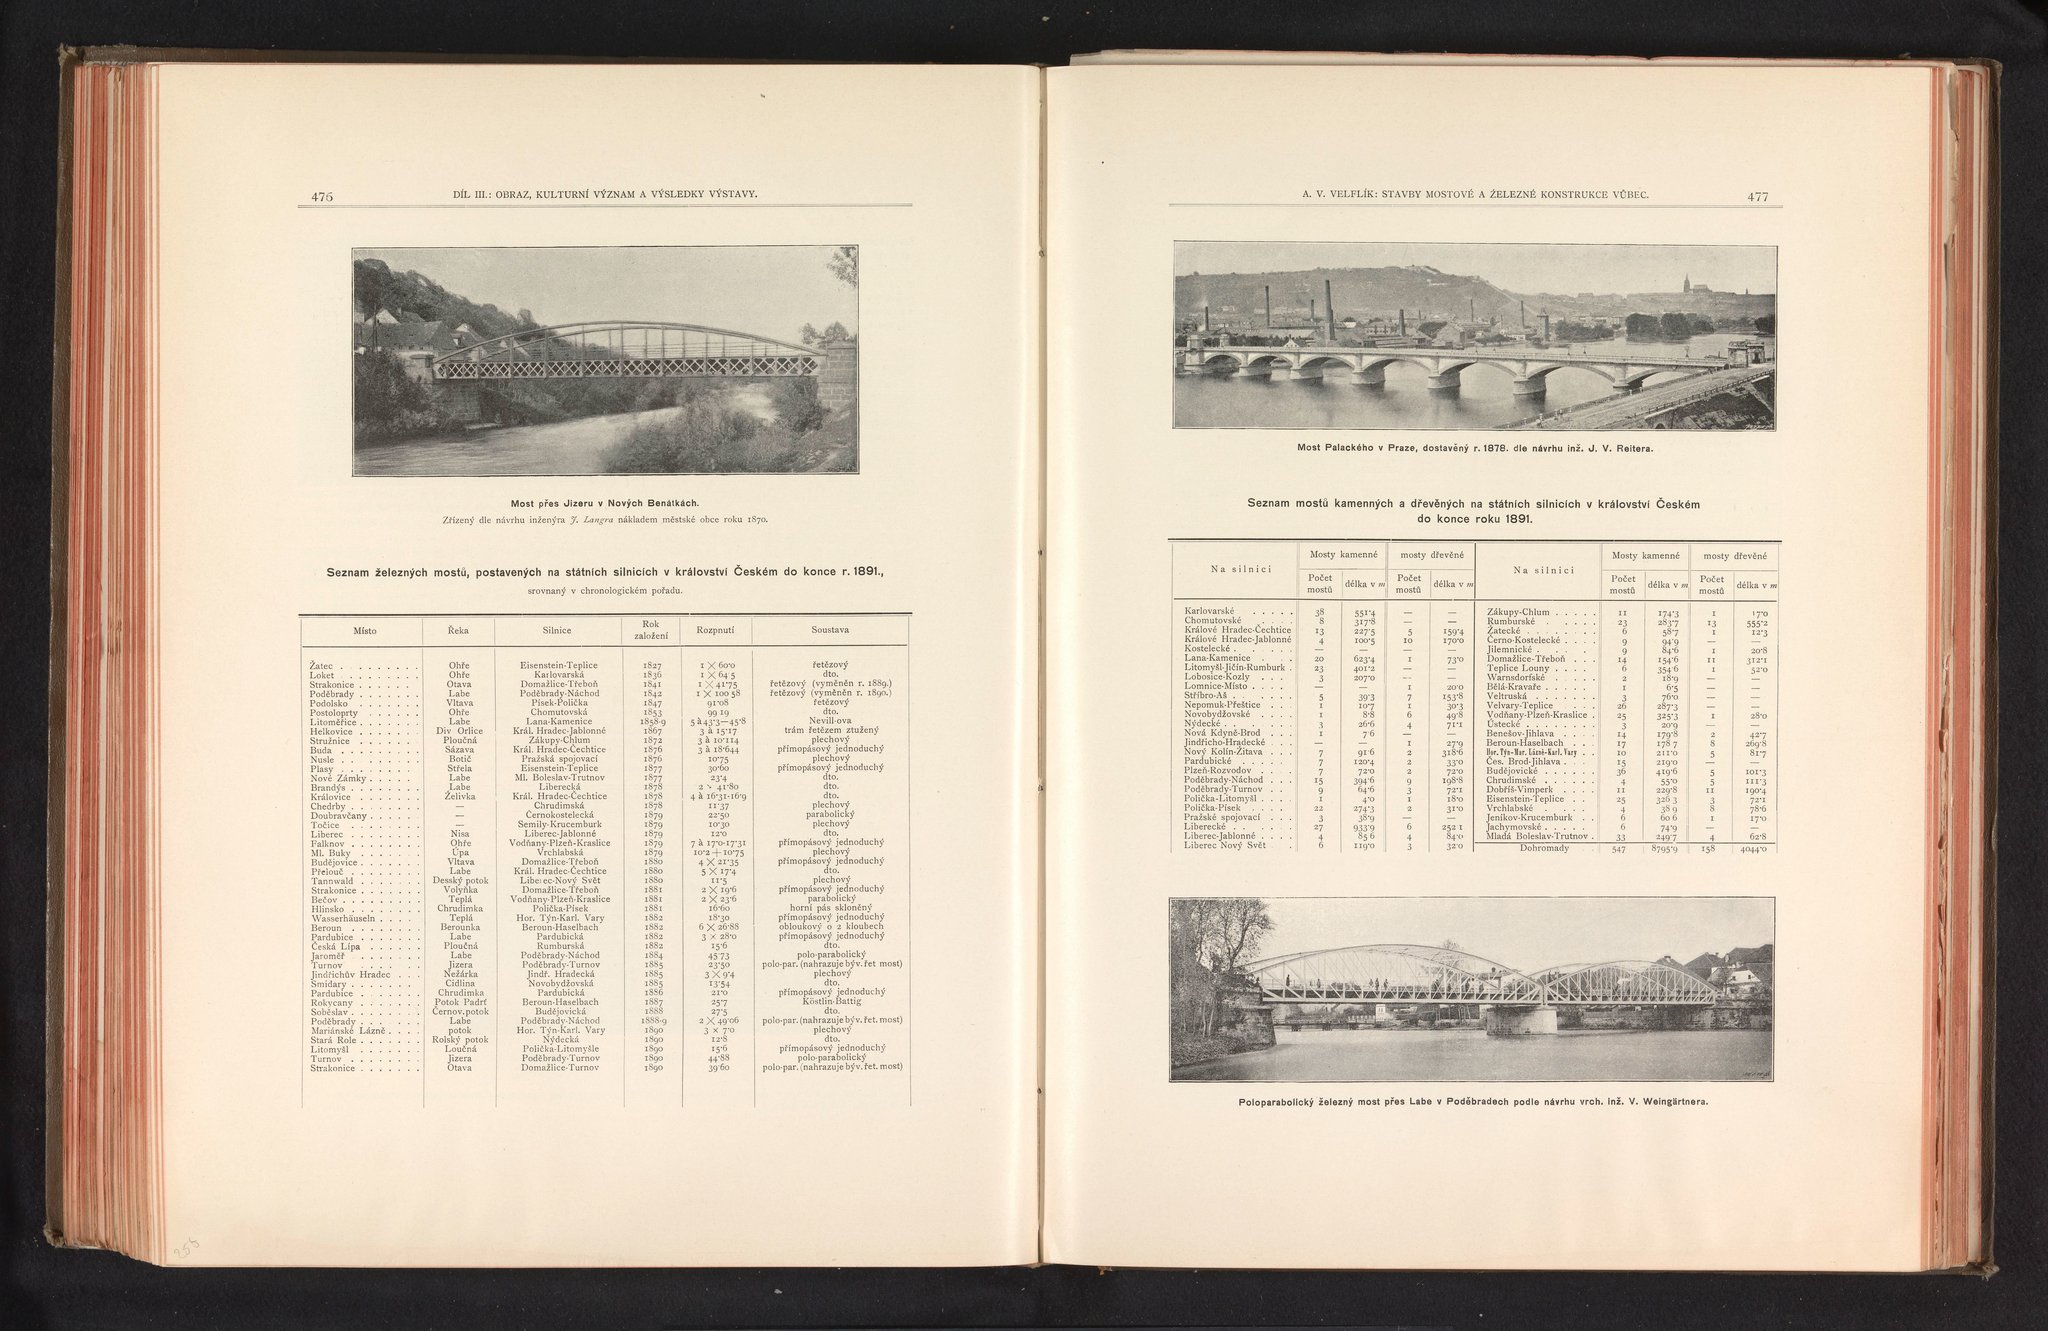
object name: page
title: Most pres Jizeru v Nových Benatikách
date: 1891-1895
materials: paper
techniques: autotype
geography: prague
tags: river, bridge